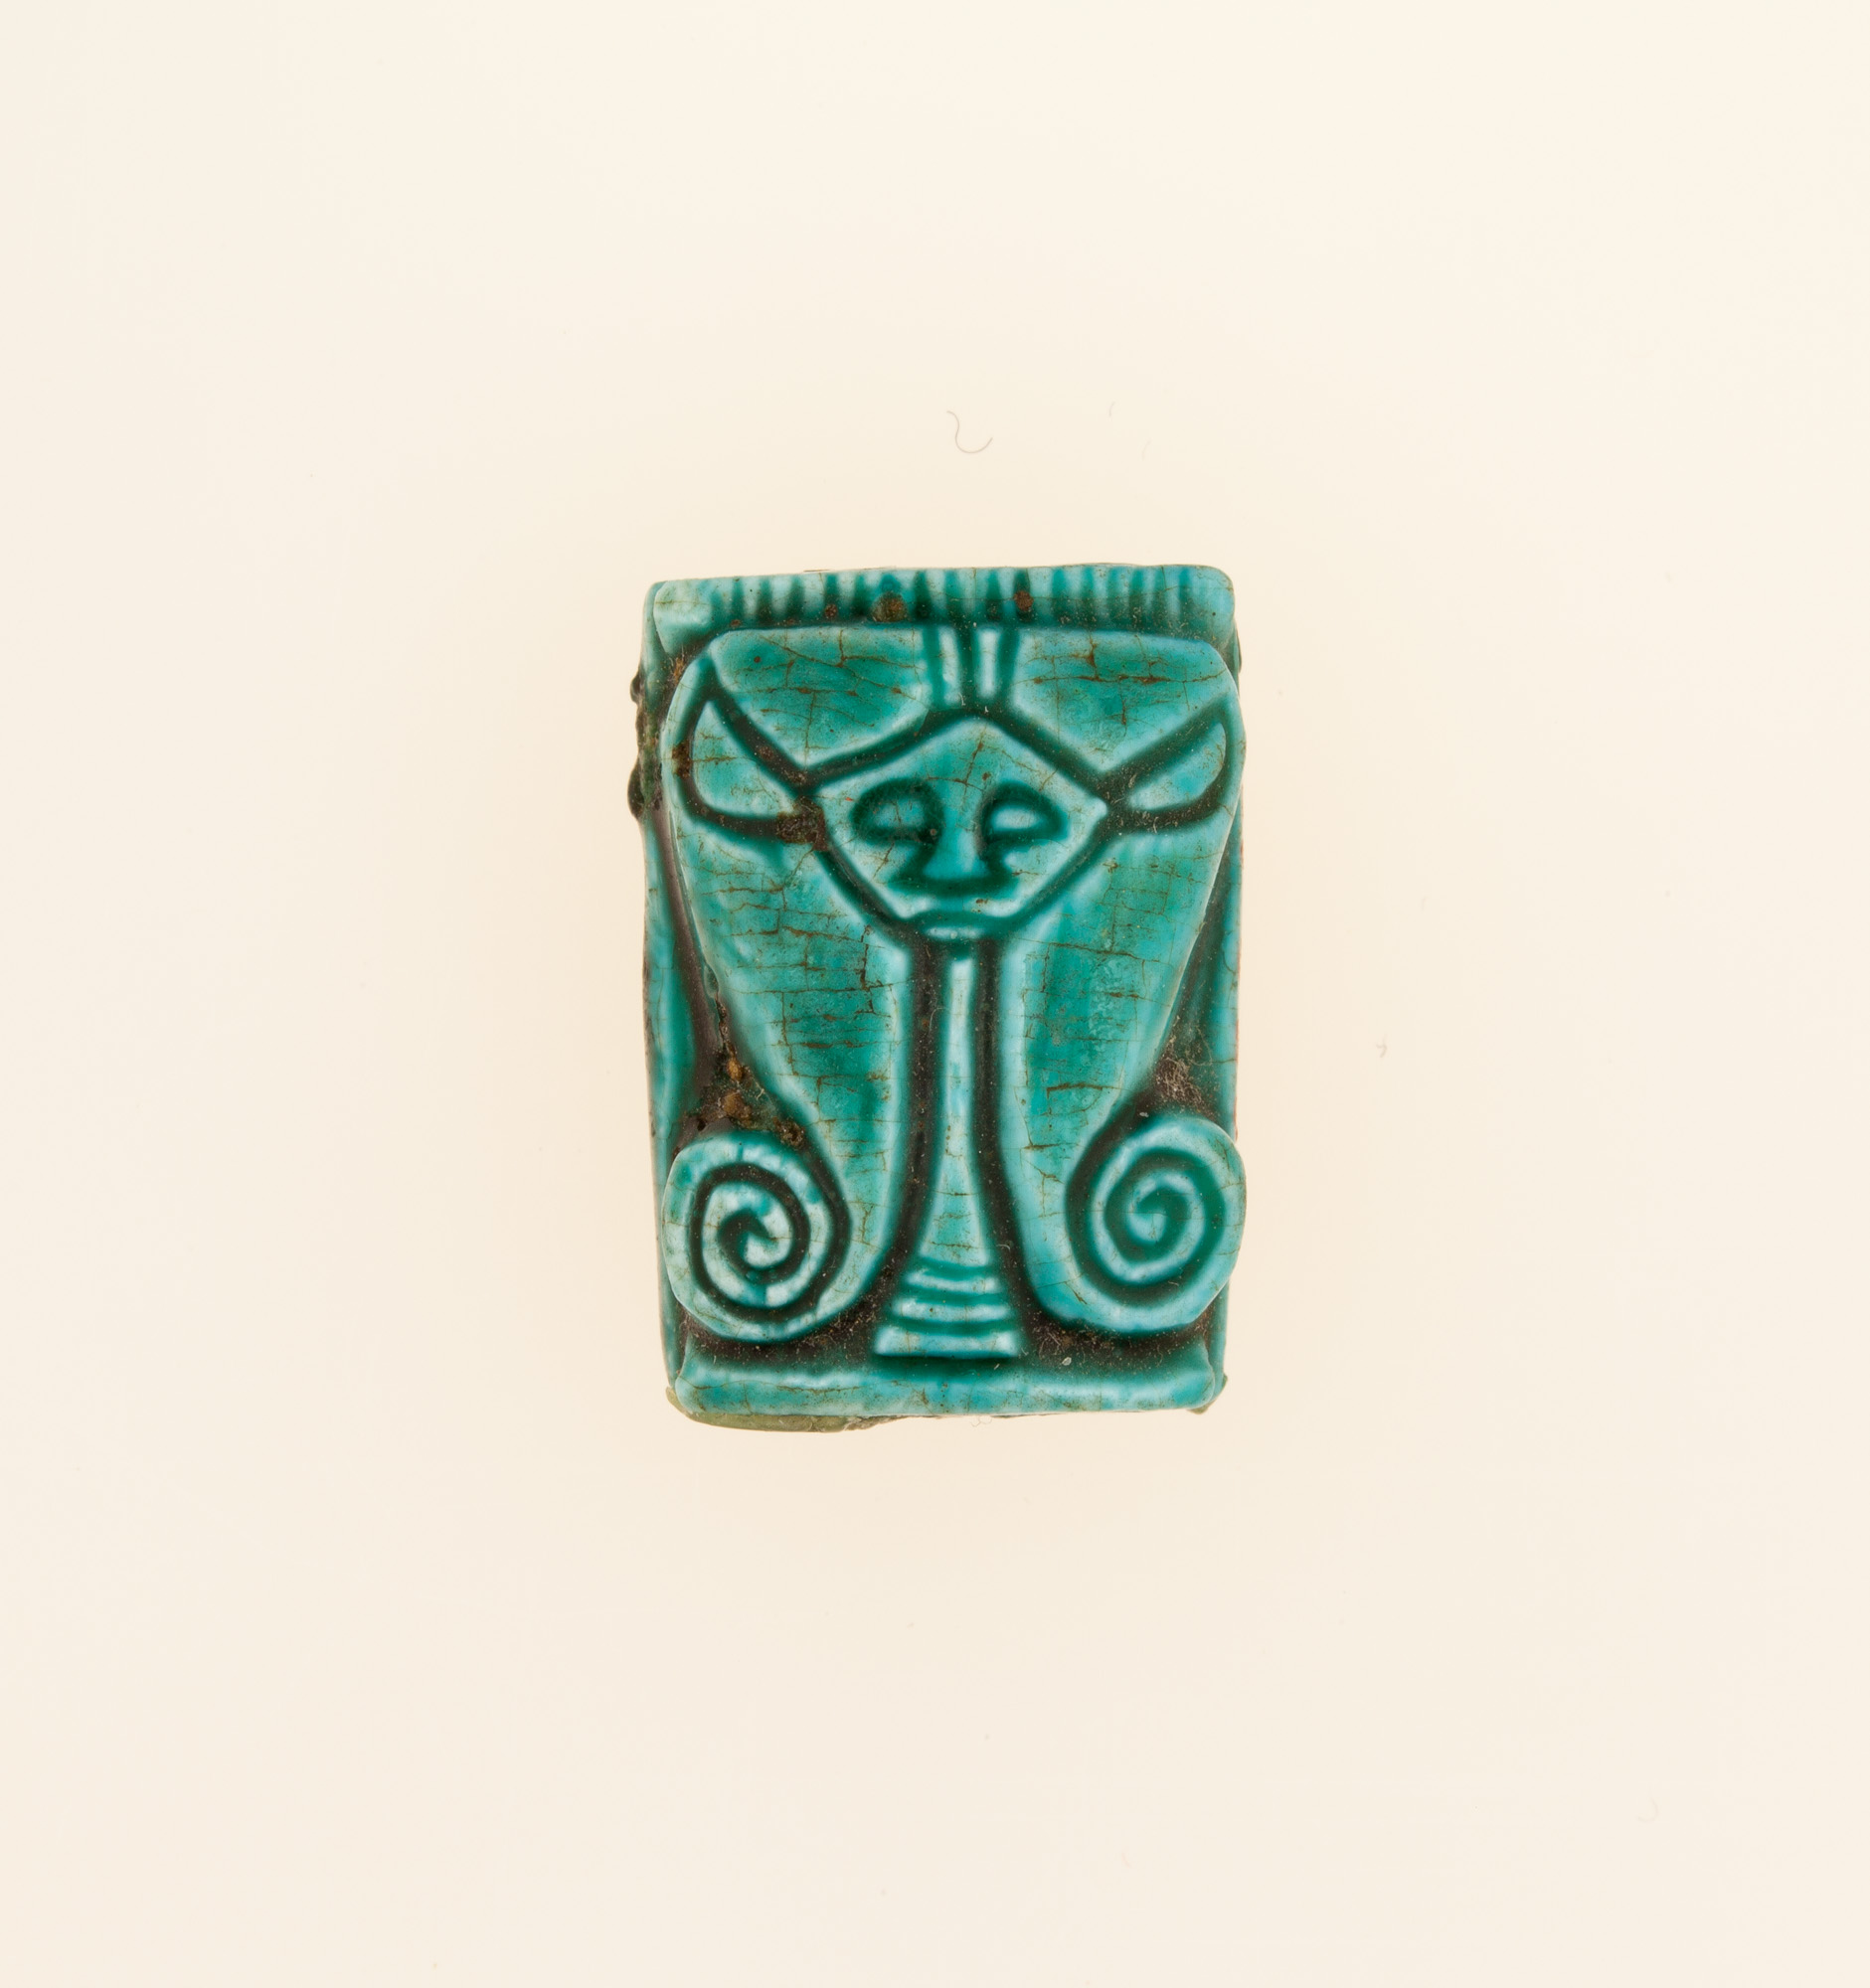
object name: bead plaque, hathor emblem, amenhotep i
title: Plaque Bead with the Name of Amenhotep I, Head of Hathor on the Reverse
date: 1525-1504 BCE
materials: faience, paint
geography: egypt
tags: hathor